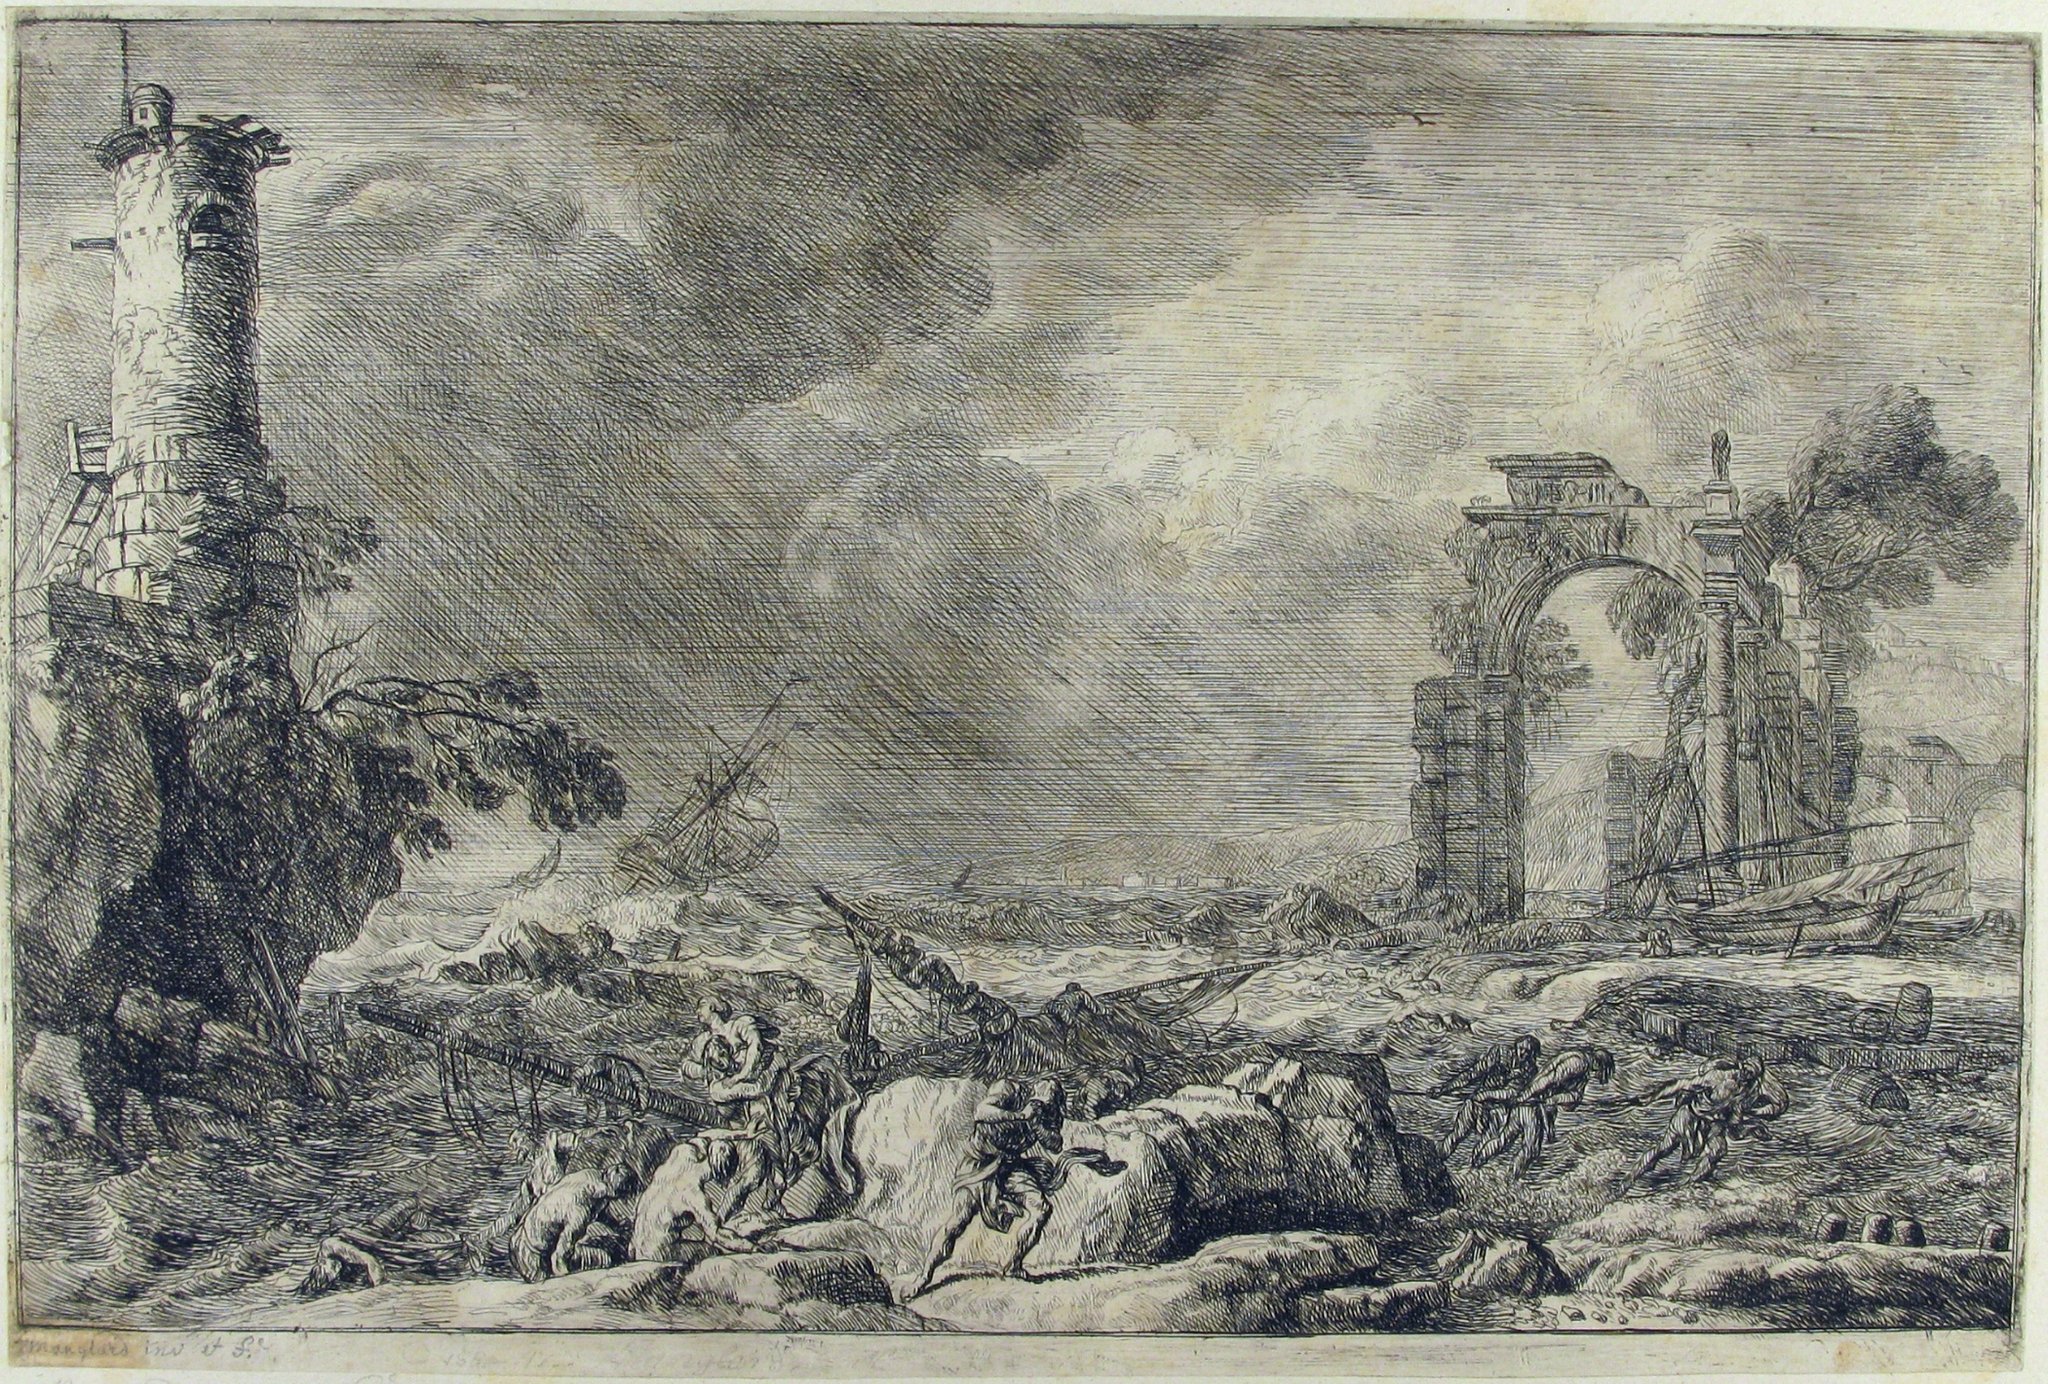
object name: print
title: Seascape (La Naufrage)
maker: adriaen manglard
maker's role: artist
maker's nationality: french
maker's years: 1695-1760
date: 1701-1800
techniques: etching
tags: ruins,seascapes,rain,storms